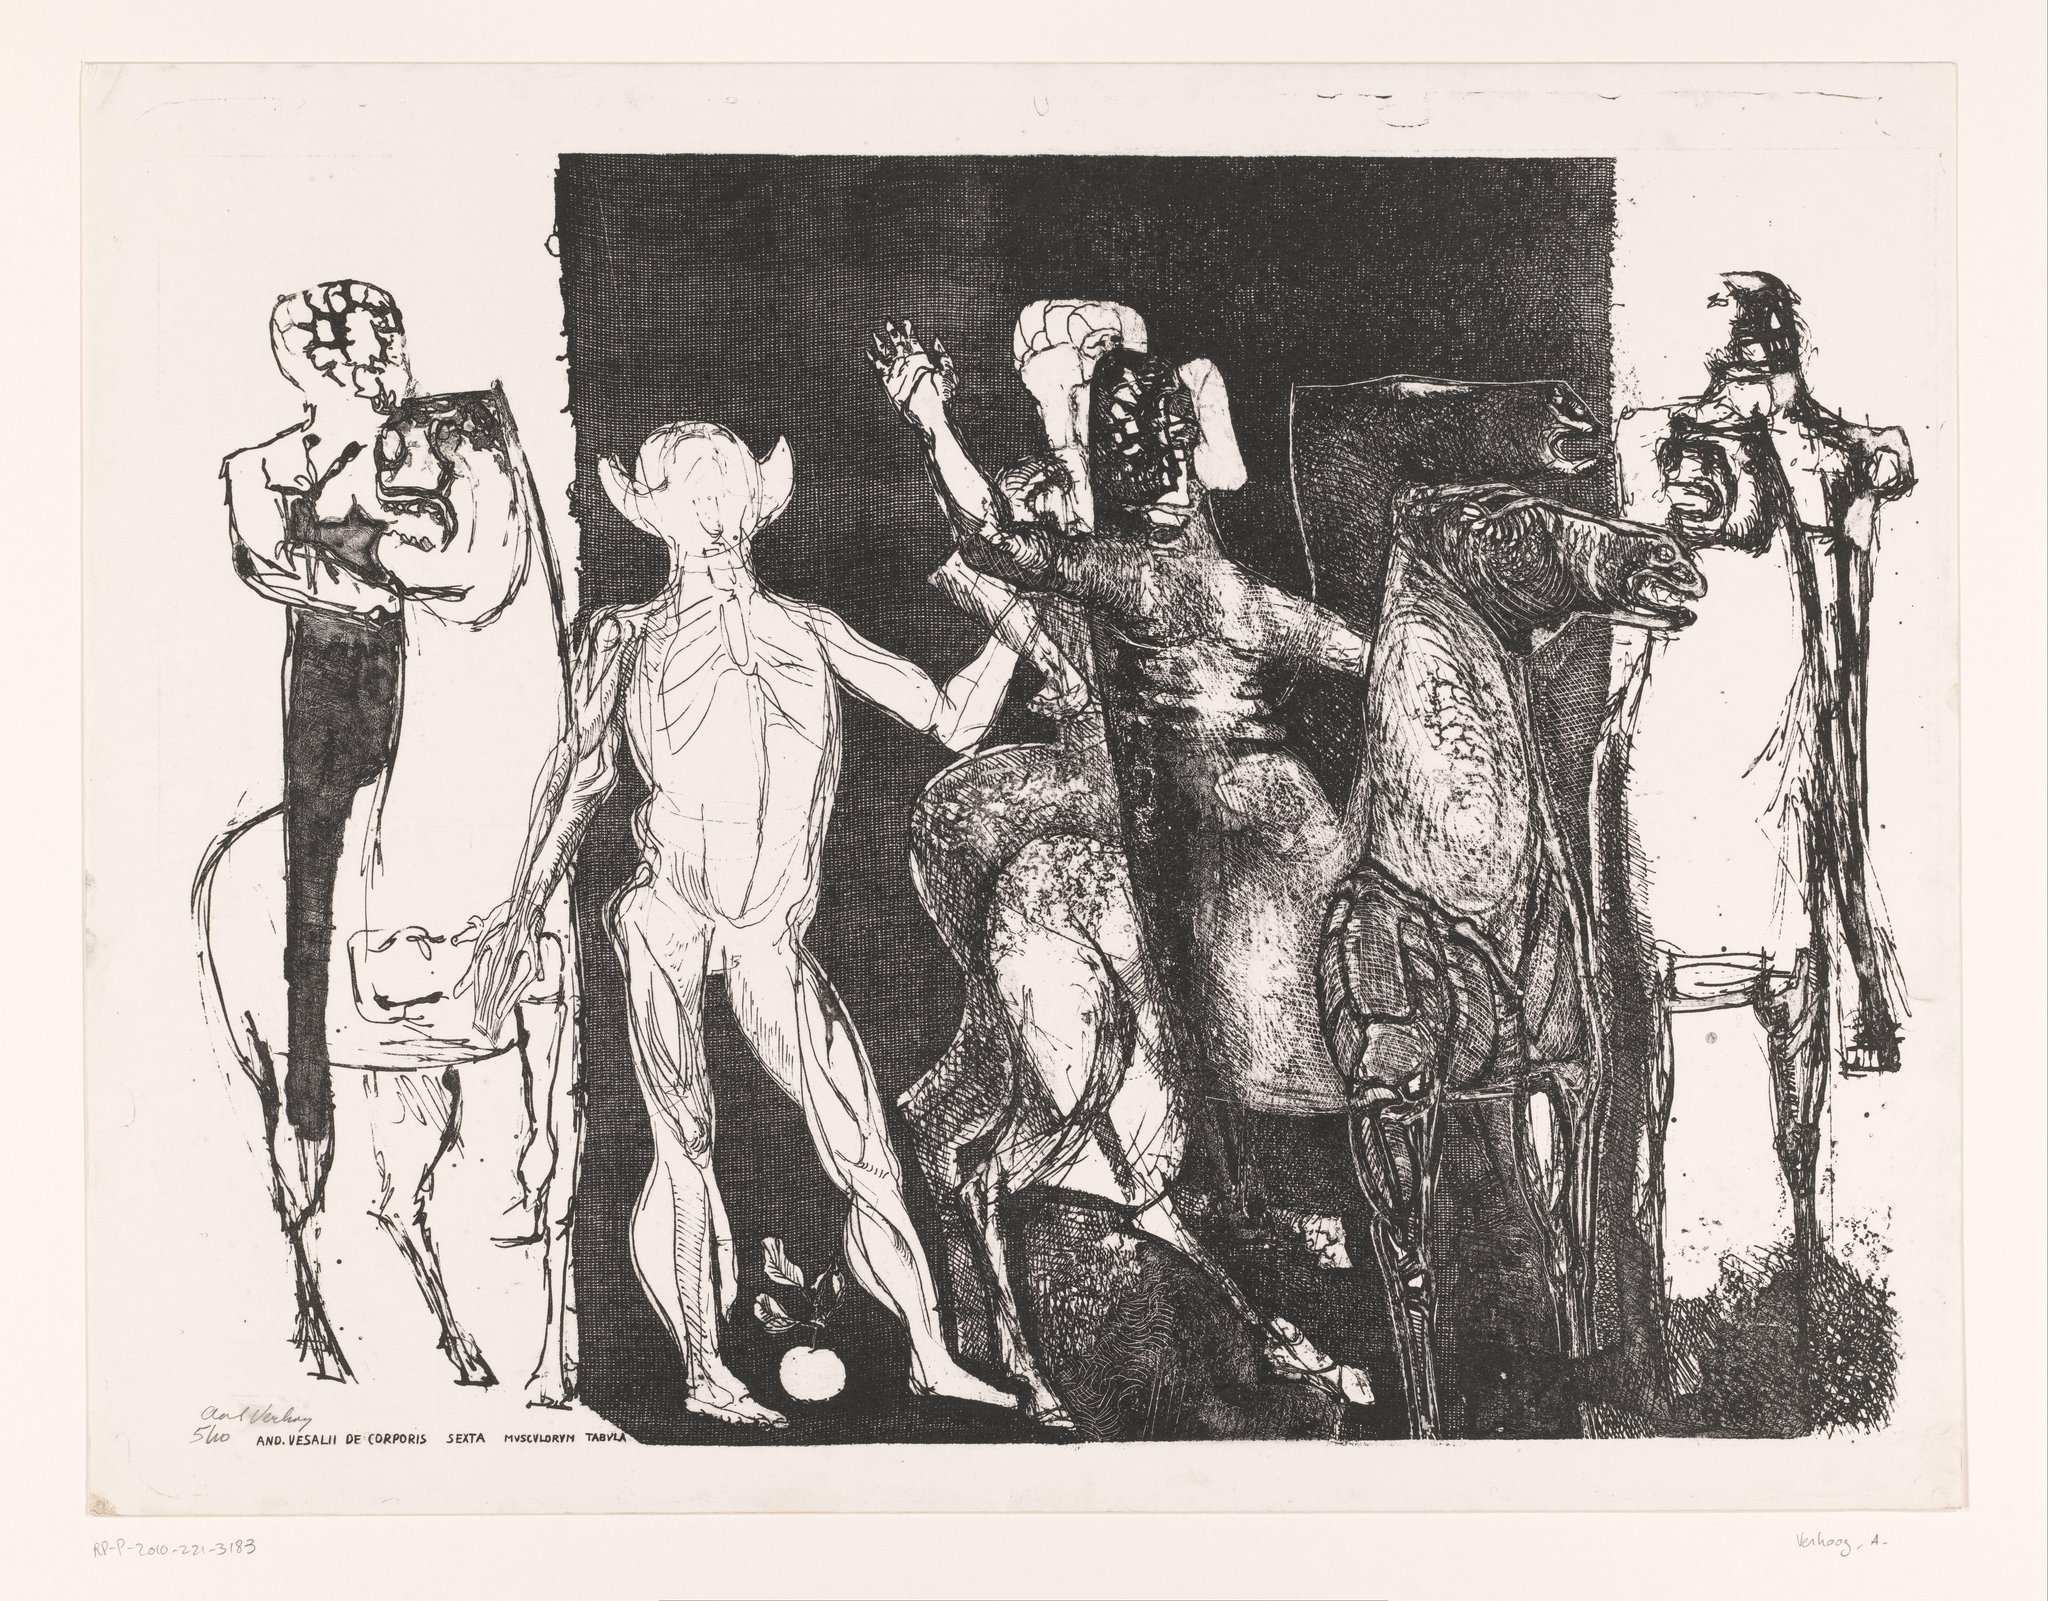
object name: print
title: Afscheid van de anatomie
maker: aat verhoog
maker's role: print maker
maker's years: 1933-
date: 1945-1963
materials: paper, ink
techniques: lithograph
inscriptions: signature: ‘Aat Verhoog’, edition: ‘5/10’, inscription: ‘AND. VESALI DE CORPORIS SEXTA MUSCULDRYM TABULA’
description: Vier gedeformeerde figuren op paarden en een staand figuur met spitse oren, allen zonder gezicht. Met links van het midden een appel.